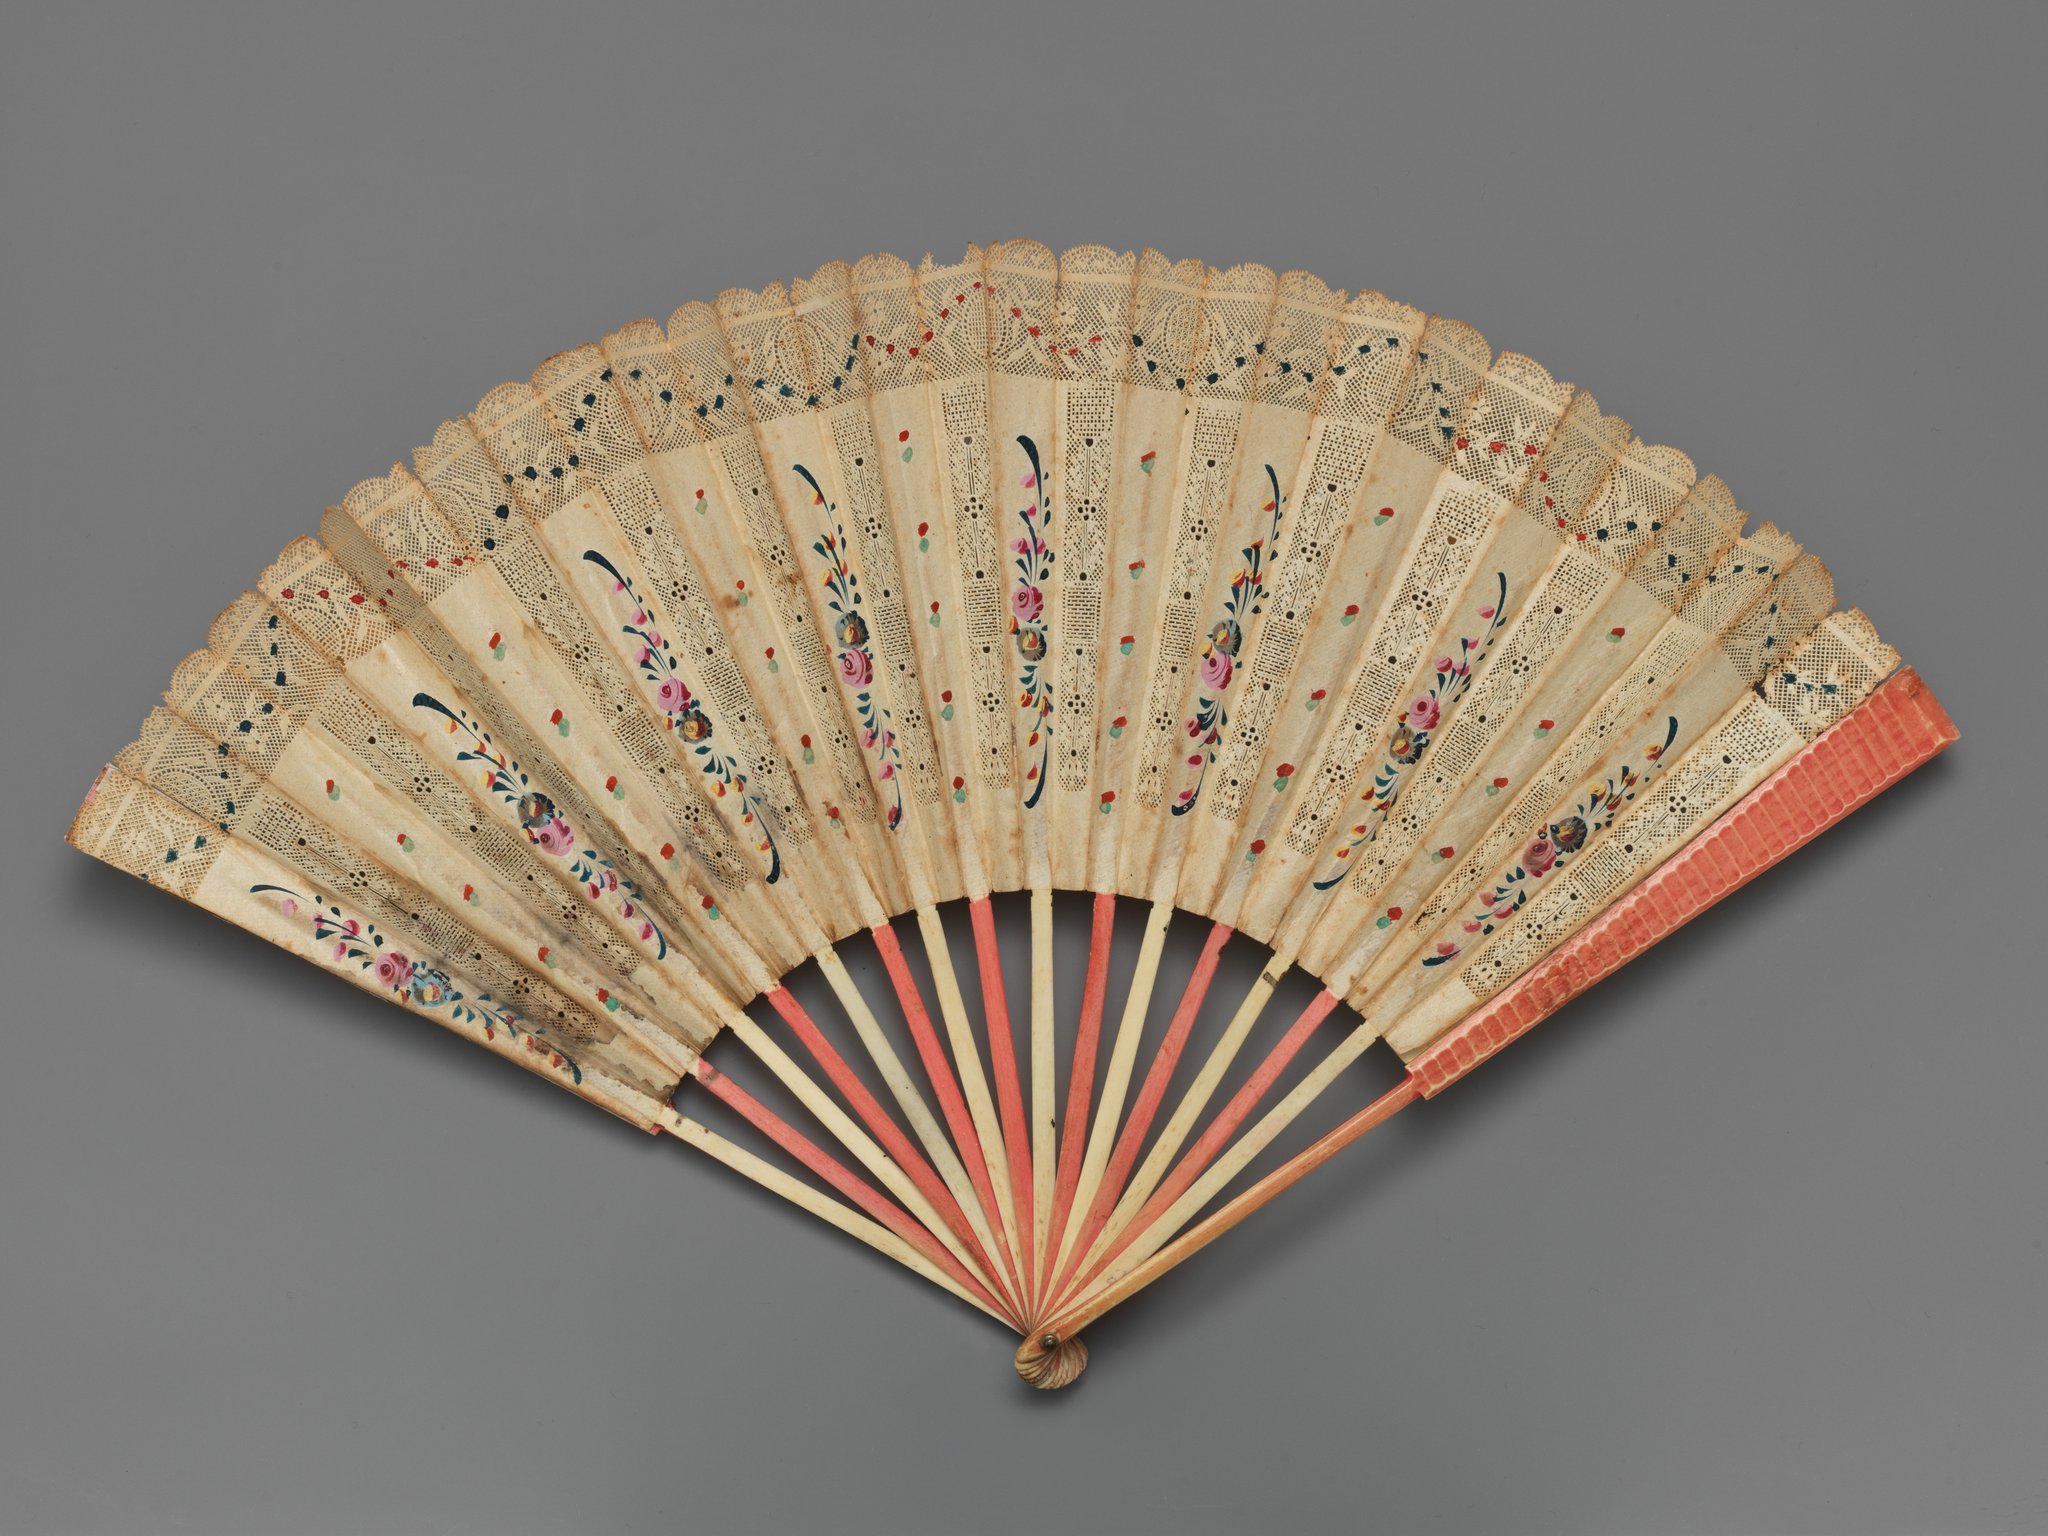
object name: fan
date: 1834-1866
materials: bone, paper